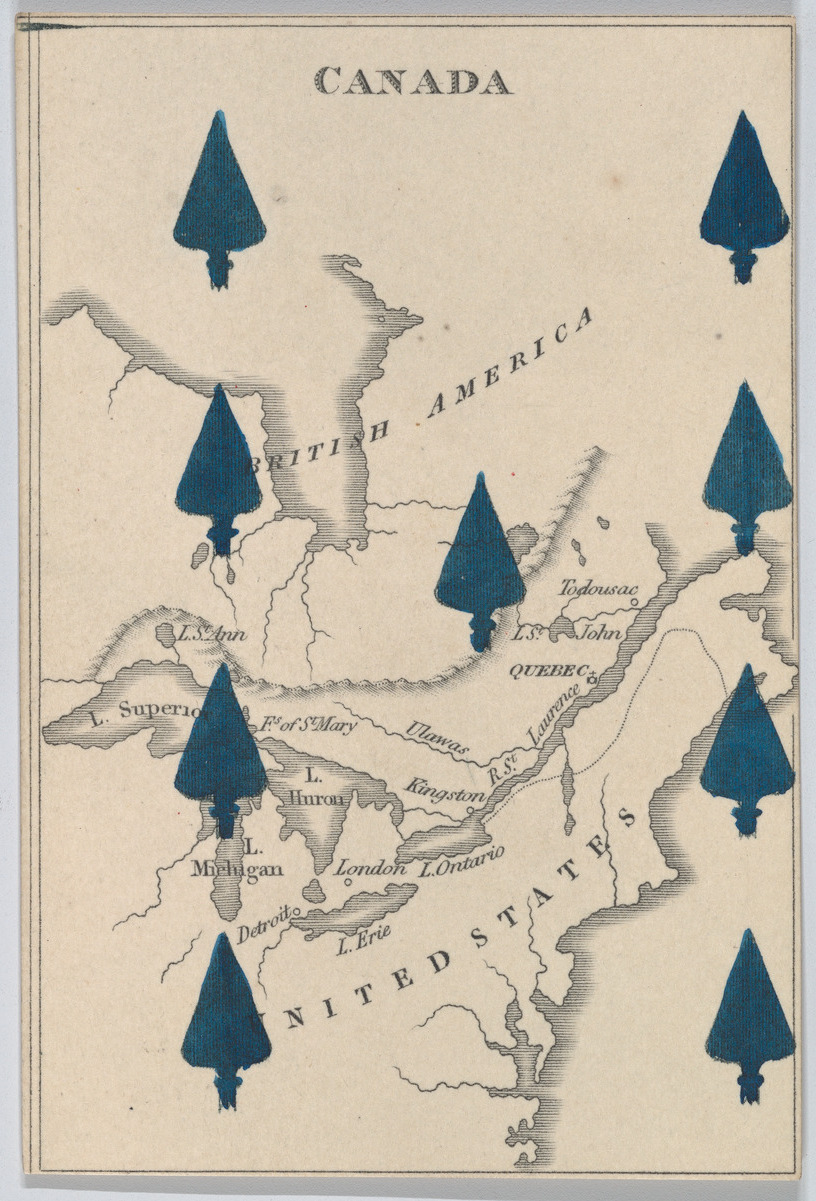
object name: print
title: Canada, from "Court Game of Geography"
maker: william and henry rock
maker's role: publisher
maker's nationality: british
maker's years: 1821-1884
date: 1838-1855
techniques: engraving, hand coloring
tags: playing cards,maps